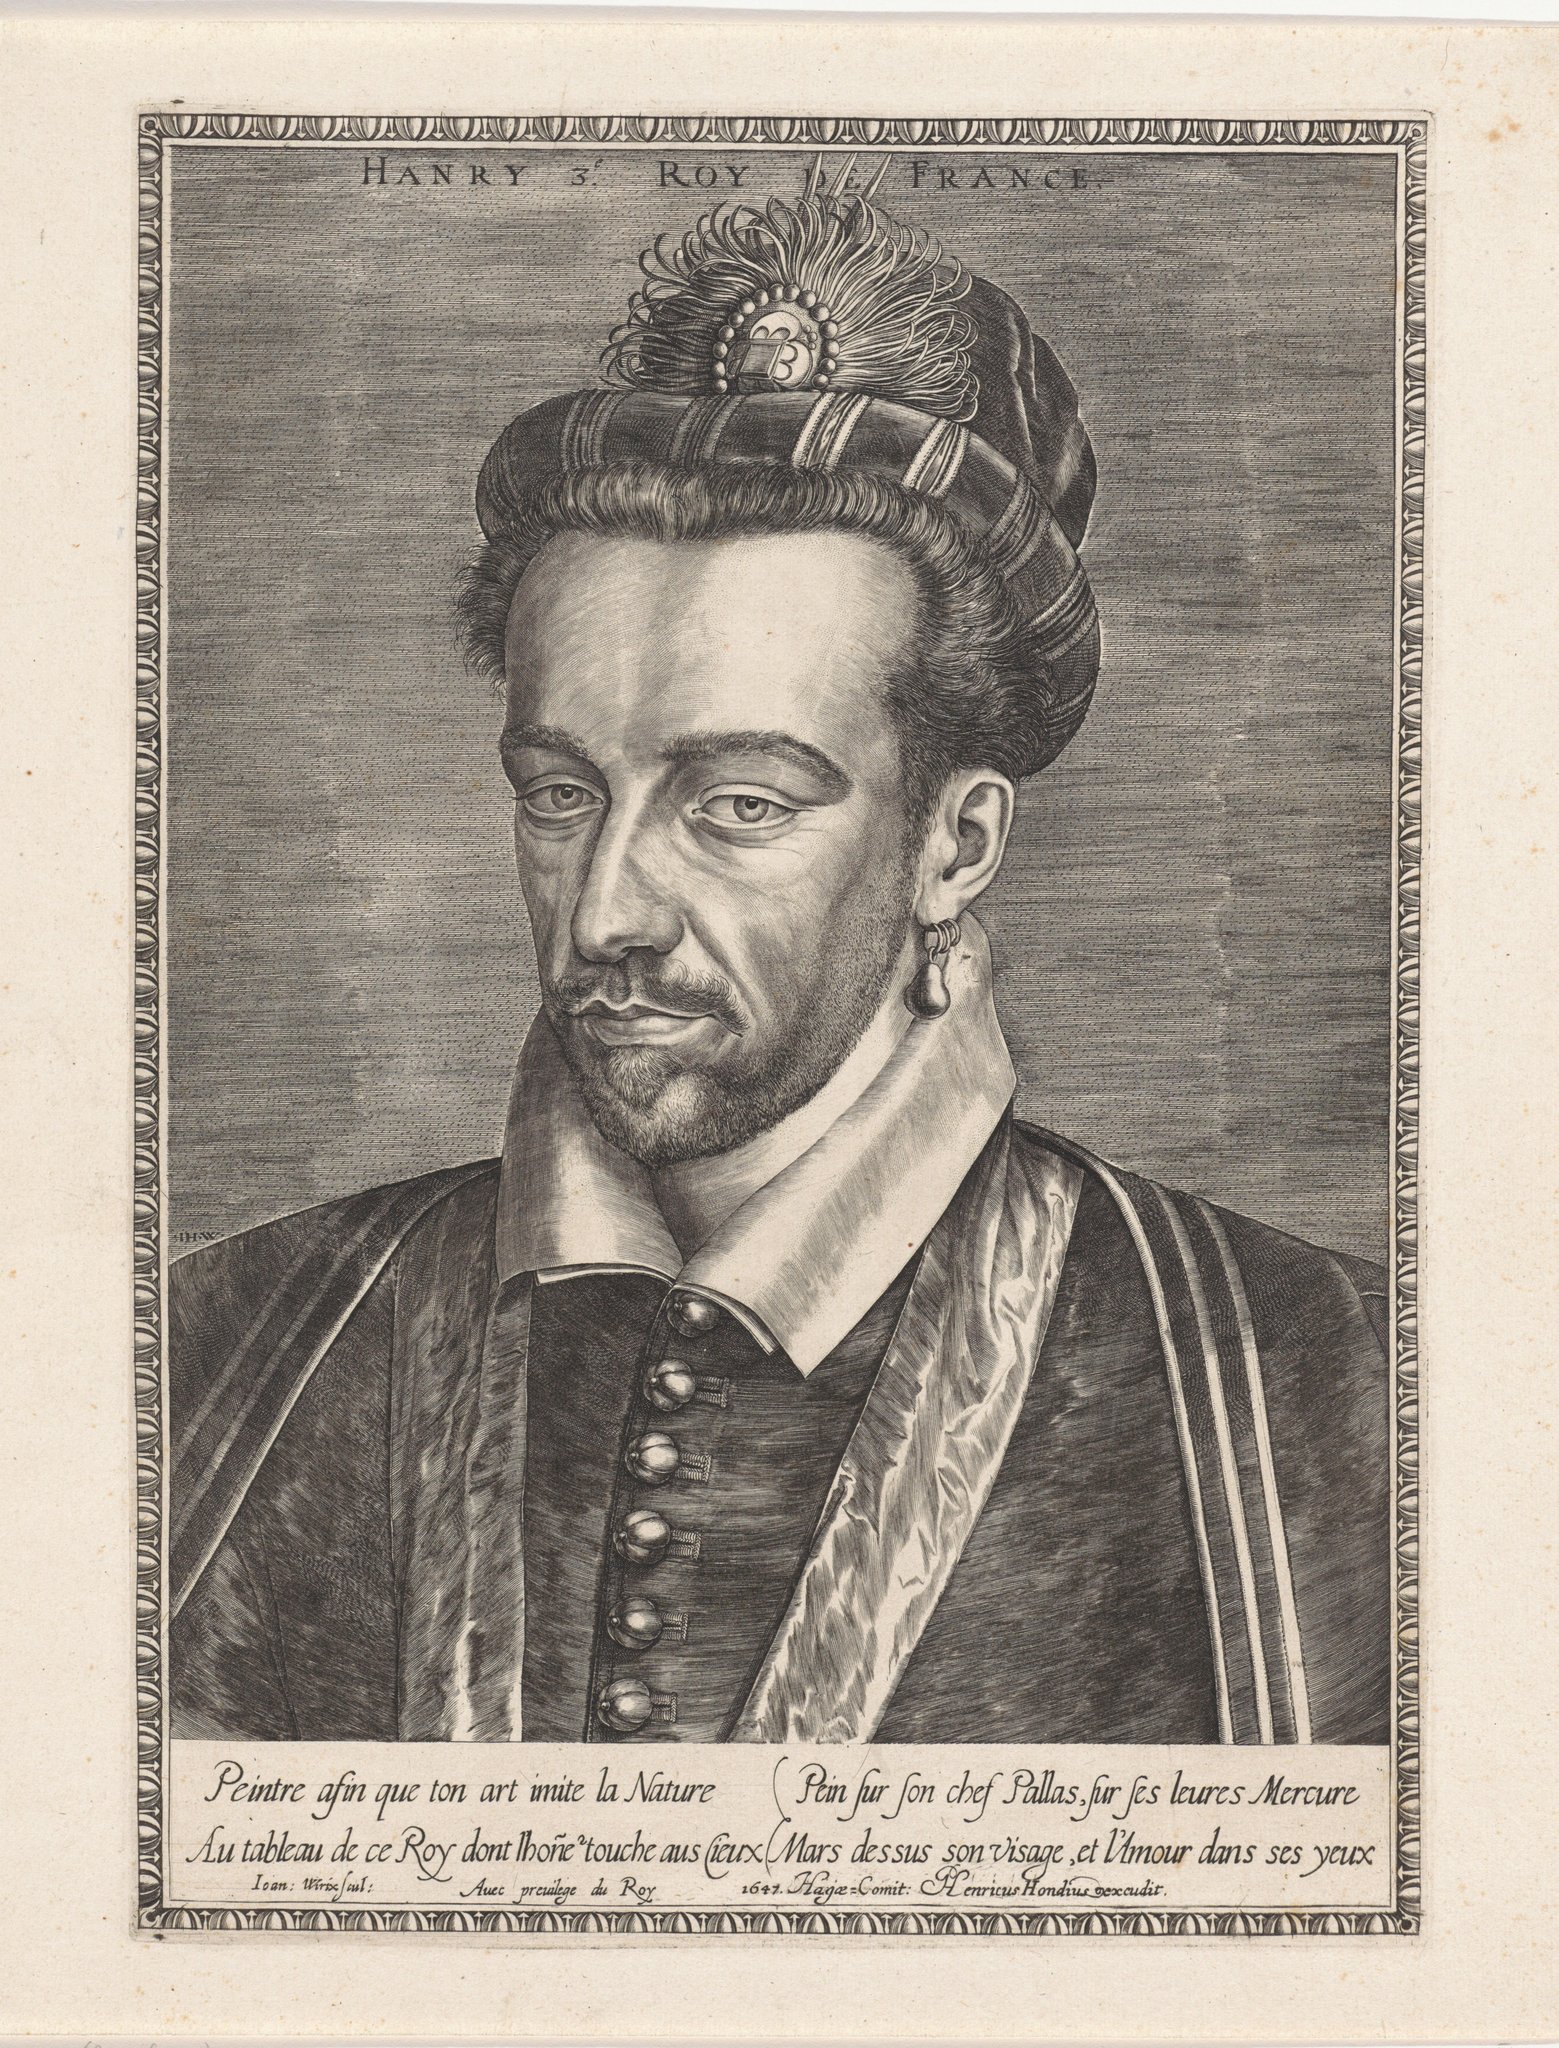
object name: print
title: Hanry 3e. Roy de France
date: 1647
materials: paper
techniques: engraving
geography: the hague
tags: hendrik iii (koning van frankrijk)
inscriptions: collector's mark: Lugt 2228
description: In de marge een vierregelig gedicht, in twee kolommen, in het Frans.